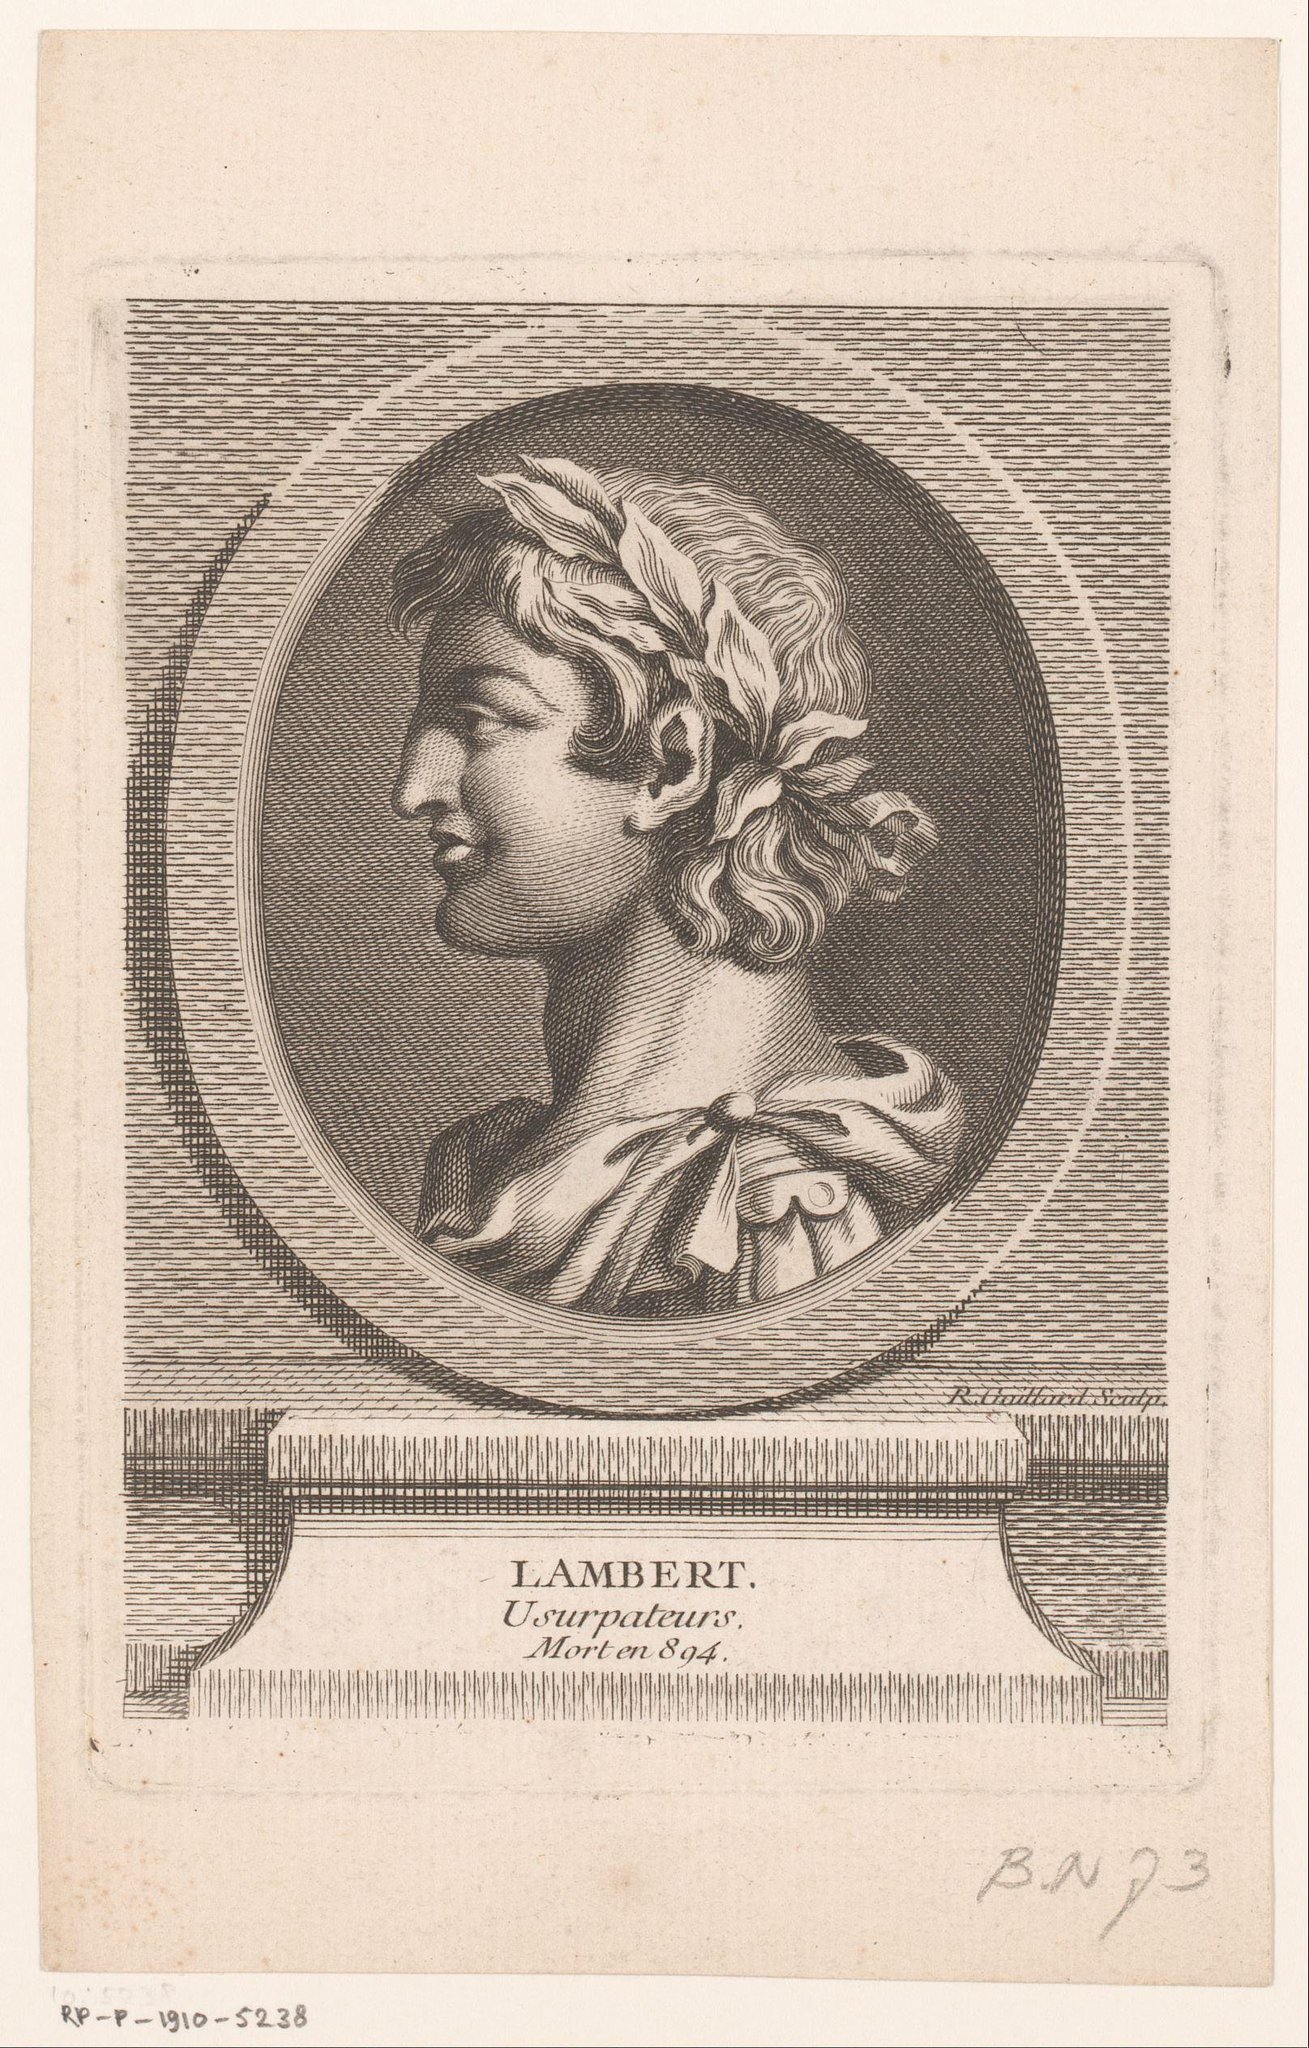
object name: print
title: Portret van Lambert II van Spoleto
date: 1755-1765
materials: paper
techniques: engraving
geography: paris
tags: historical persons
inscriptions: collector's mark: Lugt 2228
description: Mogelijk prent uit: Dreux du Radier, Jean-François. L'Europe illustré, contenant l'histoire abregée des souverains, des princes, des prélats, des ministres, (...) en Europe: dans le XVe. siècle compris, jusqu'à présent. Parijs: Michel Odieuvre en André-François Le Breton, 1755-1765, dl. 1.